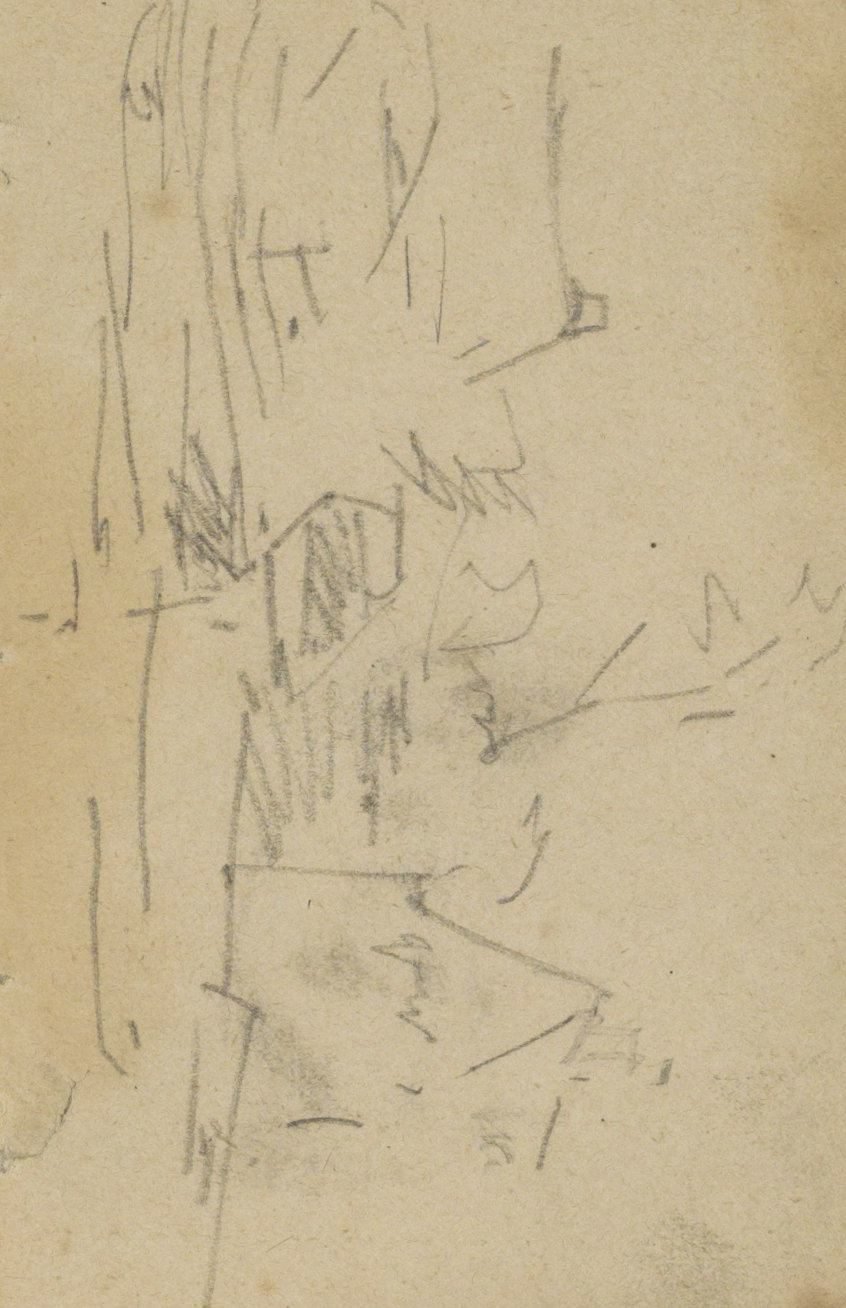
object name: sketchbook leaf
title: Gebouwen, mogelijk boerderijen, in een landschap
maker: george hendrik breitner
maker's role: draughtsman, painter, print maker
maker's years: 1857-1923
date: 1881-1883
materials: chalk, paper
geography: south holland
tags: landscapes, rural housing, e.g. country-house, villa, cottage, farm (building)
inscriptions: kleurnotitie, handgeschreven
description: Gebouwen, mogelijk boerderijen, in een landschap. Pagina 73 uit een schetsboek met 43 bladen.